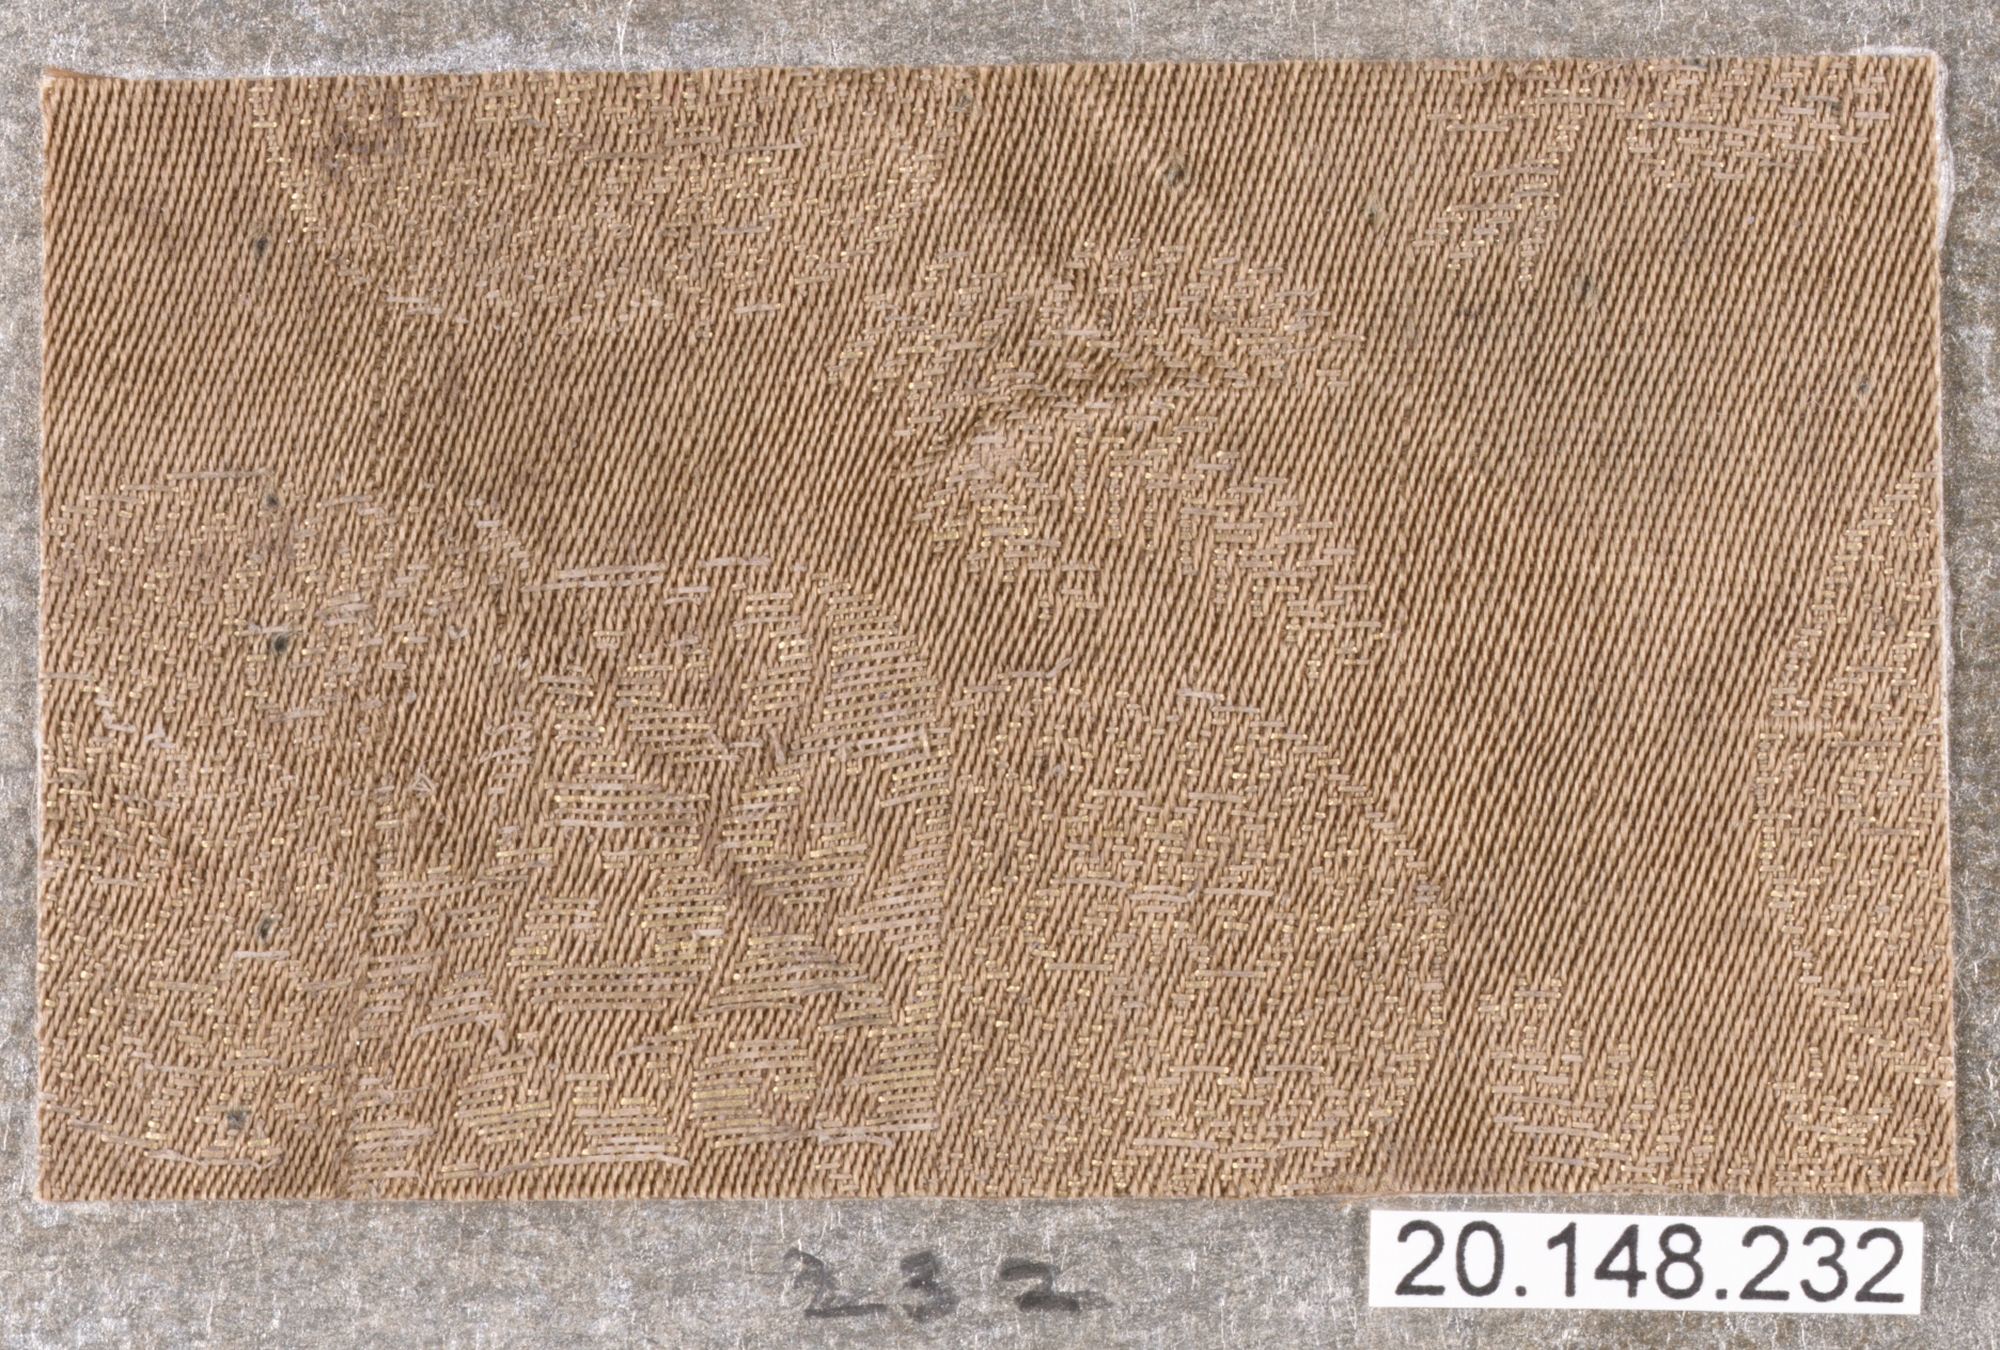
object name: piece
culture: japanese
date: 1601-1700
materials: silk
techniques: compound weave